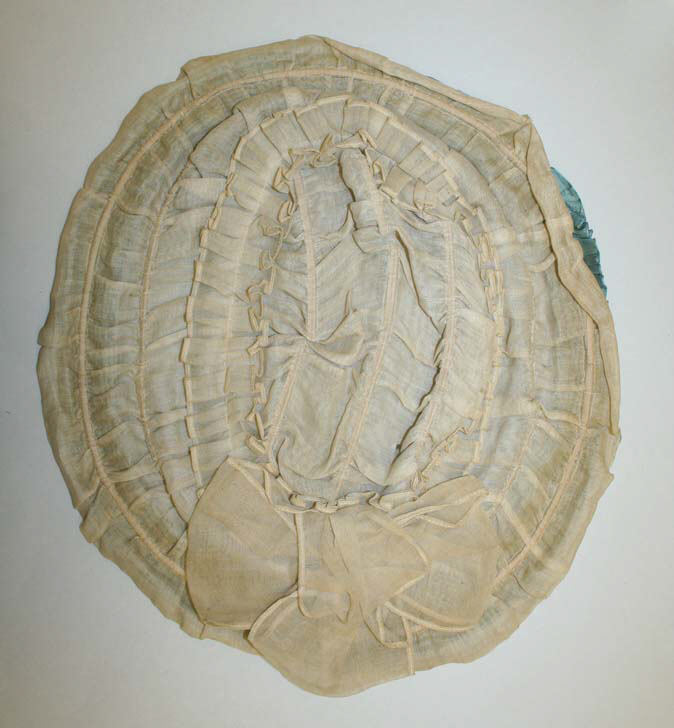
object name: hat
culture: american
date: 1870-1879